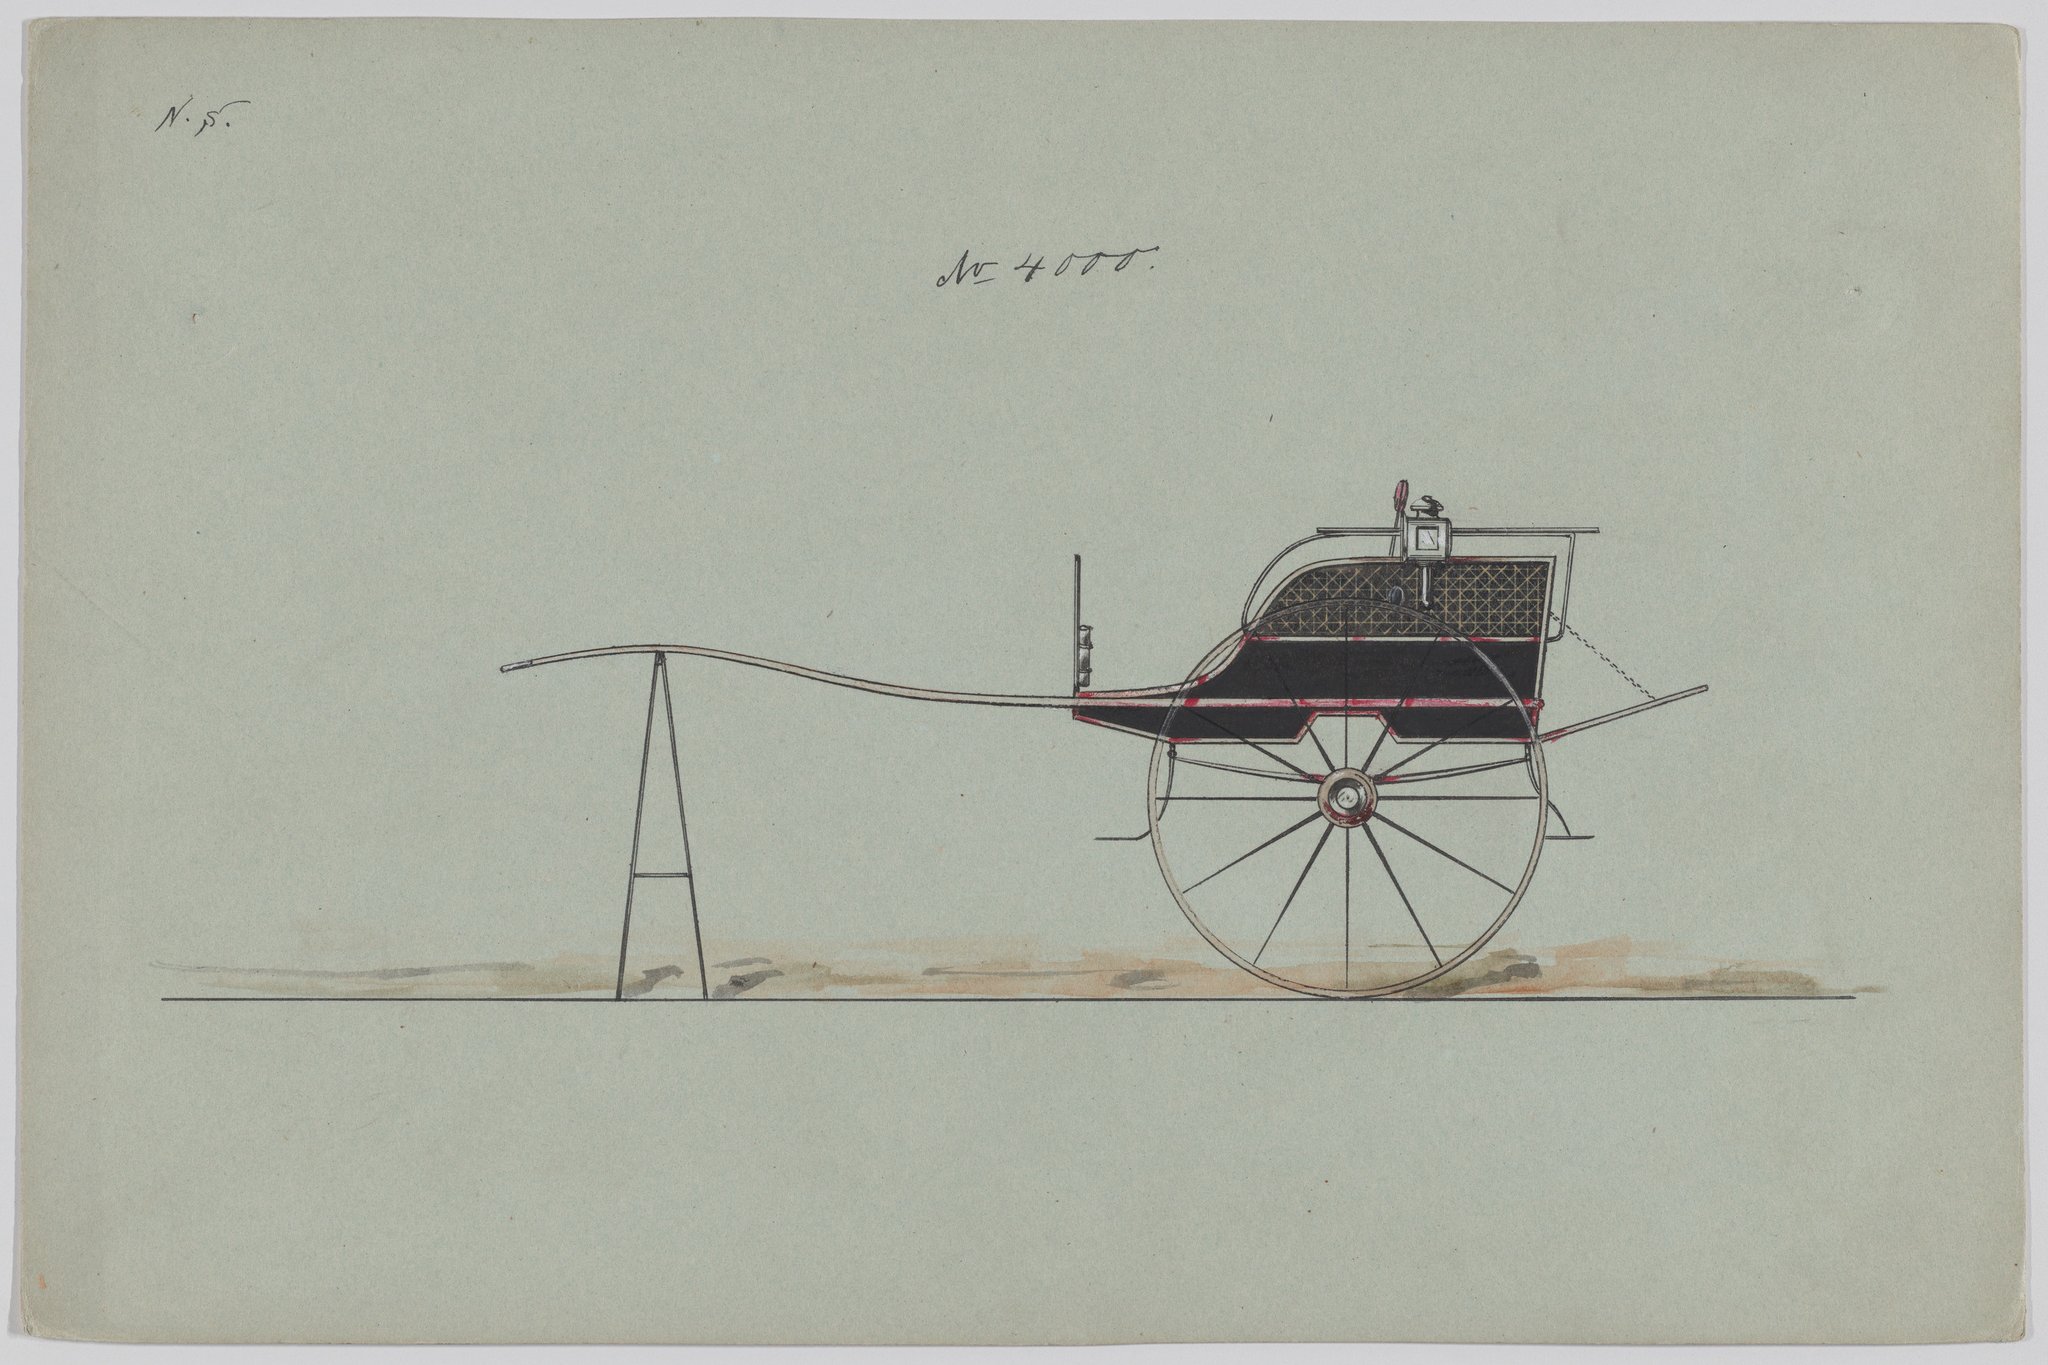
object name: drawing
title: Design for Dog Cart or 2 Wheeler, no. 4000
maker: brewster & co.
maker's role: manufacturer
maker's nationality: american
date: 1887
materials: gouache, ink, watercolor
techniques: pen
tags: carriages